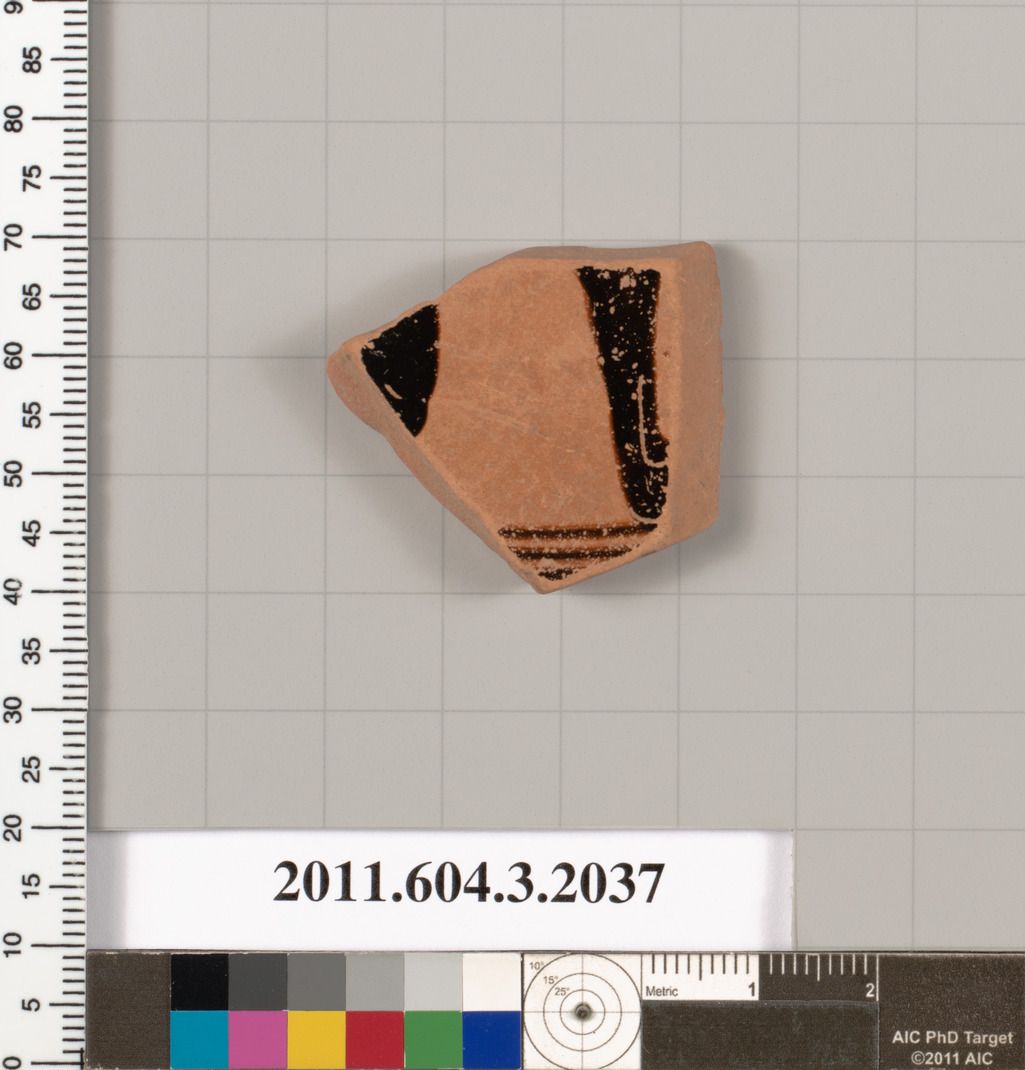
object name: kylix fragment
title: Terracotta fragment of a kylix (drinking cup)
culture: greek, attic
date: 500-468 BCE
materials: terracotta